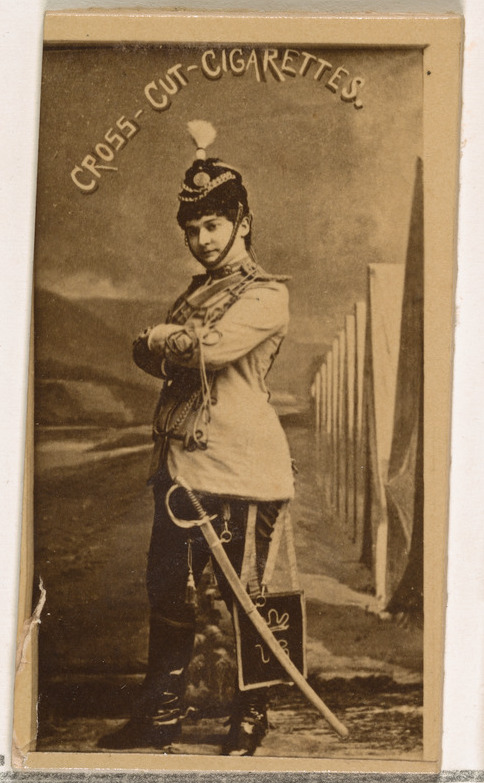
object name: print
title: Actress wearing military costume with sword, from the Actors and Actresses series (N145-1) issued by Duke Sons & Co. to promote Cross Cut Cigarettes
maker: w. duke, sons & co.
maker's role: publisher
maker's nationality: american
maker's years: 1870-1920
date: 1880-1889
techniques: albumen silver print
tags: portraits,women,actresses